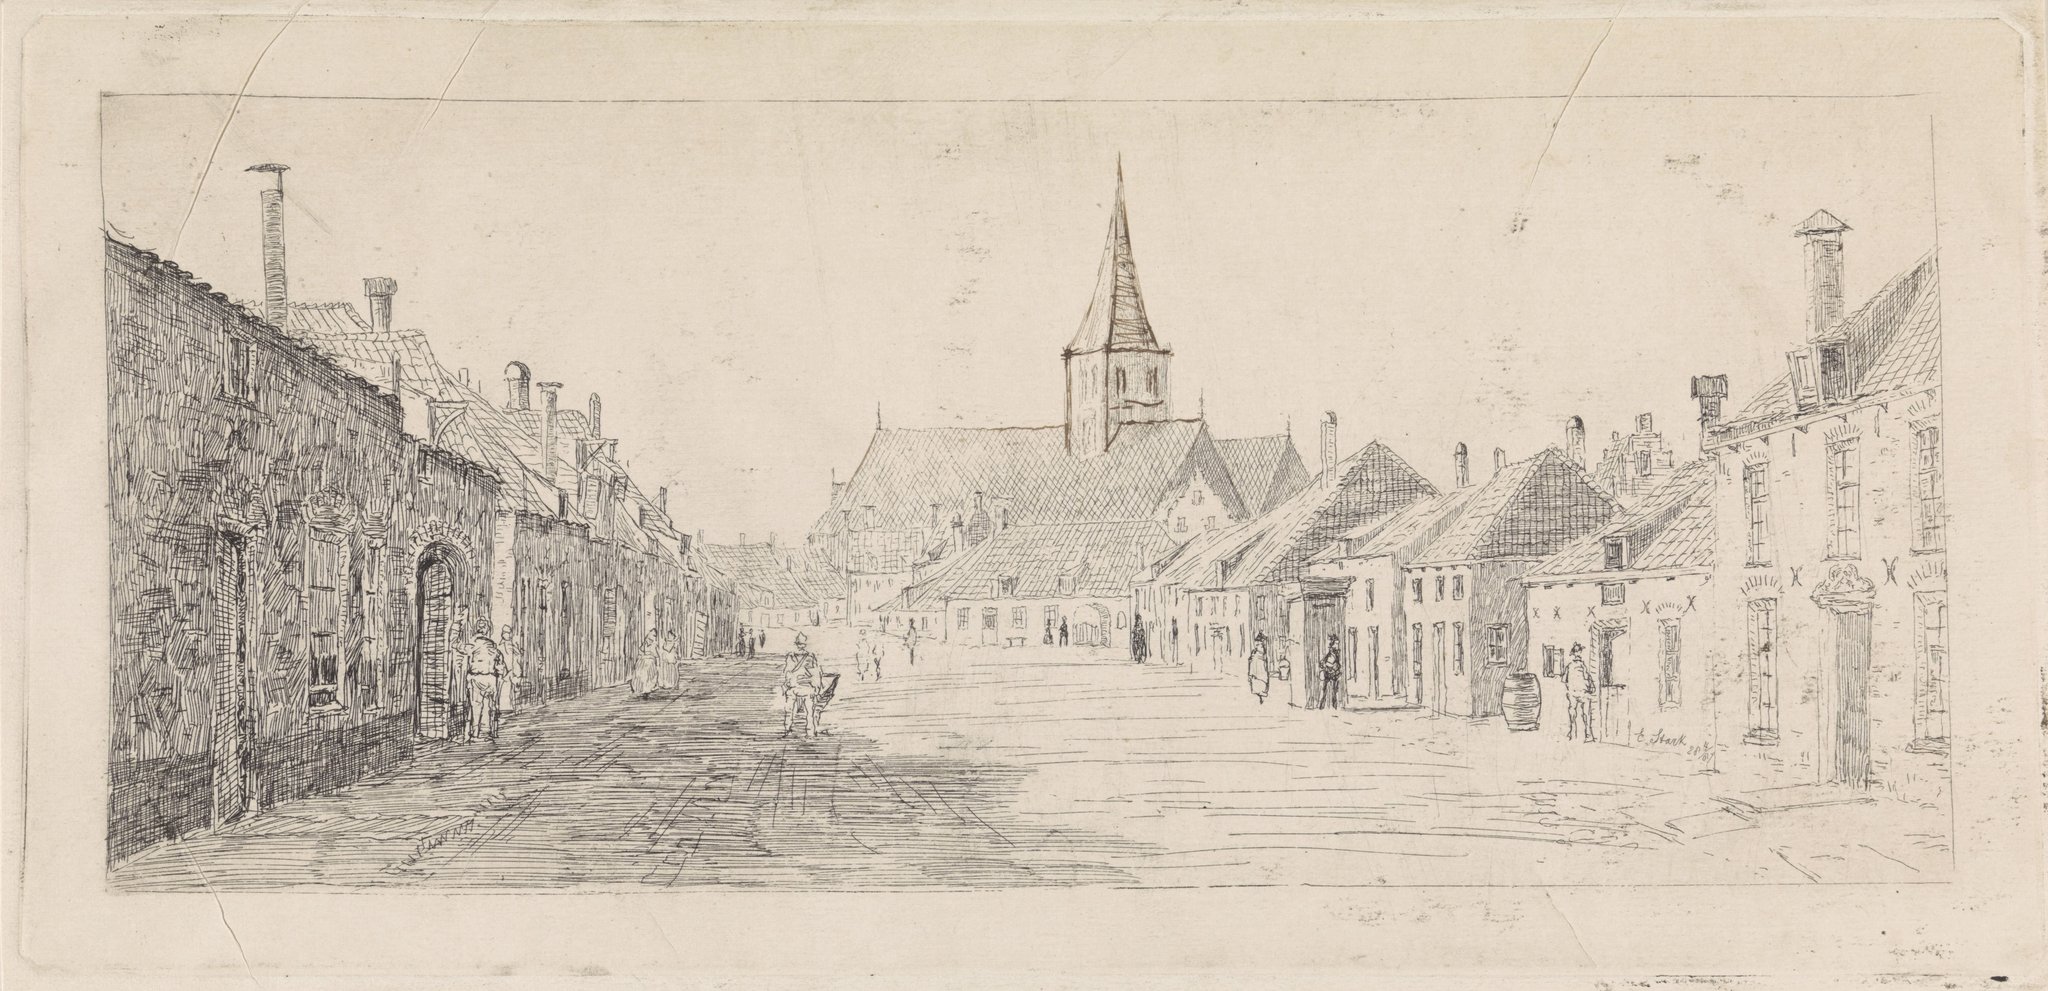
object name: print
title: Straat in Amersfoort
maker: elias stark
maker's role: draughtsman, print maker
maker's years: 1849-1933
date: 1887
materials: paper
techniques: etching, pen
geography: nieuwer-amstel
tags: village street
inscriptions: collector's mark: Lugt 2228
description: Straat in de stad Amersfoort met aan het einde de Sint-Joriskerk.